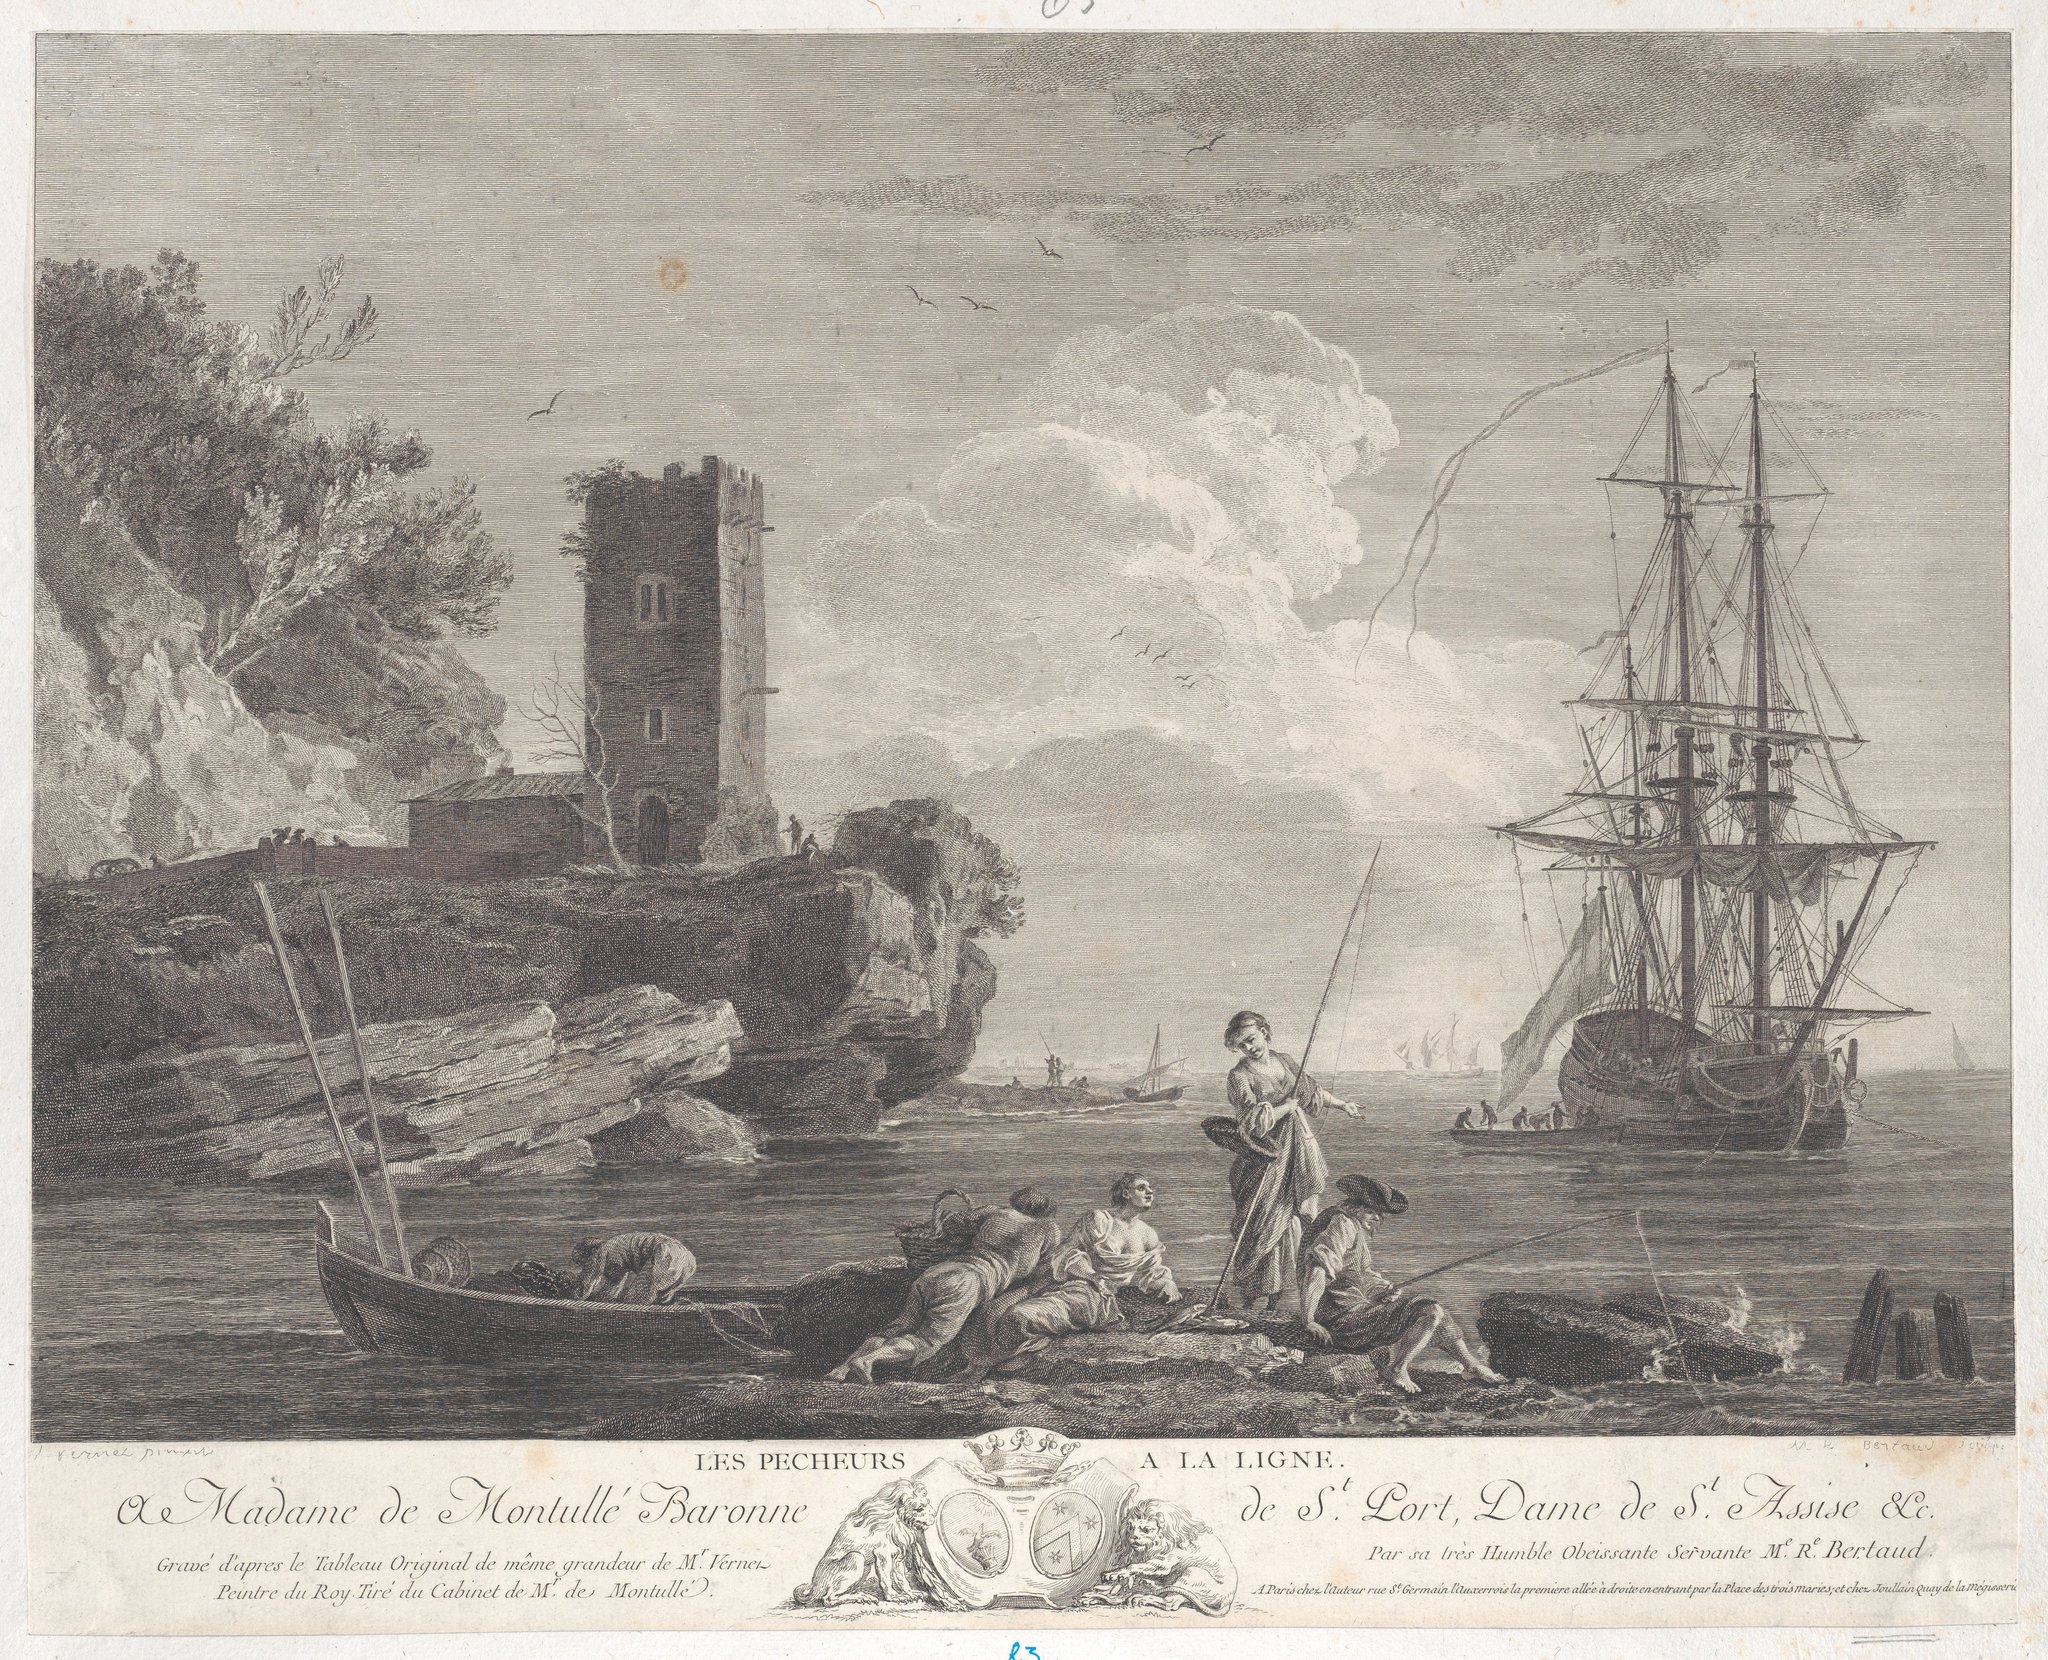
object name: print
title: The Fishermen with their Lines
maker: joseph vernet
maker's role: artist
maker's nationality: french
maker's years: 1714-1789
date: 1770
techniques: engraving